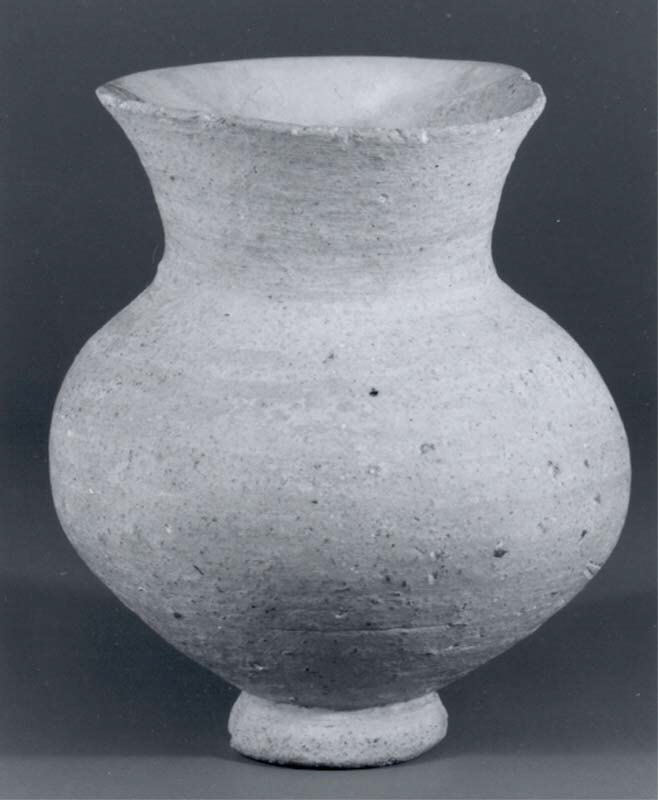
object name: jar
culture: iranian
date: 1700-1501 BCE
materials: ceramic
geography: iran